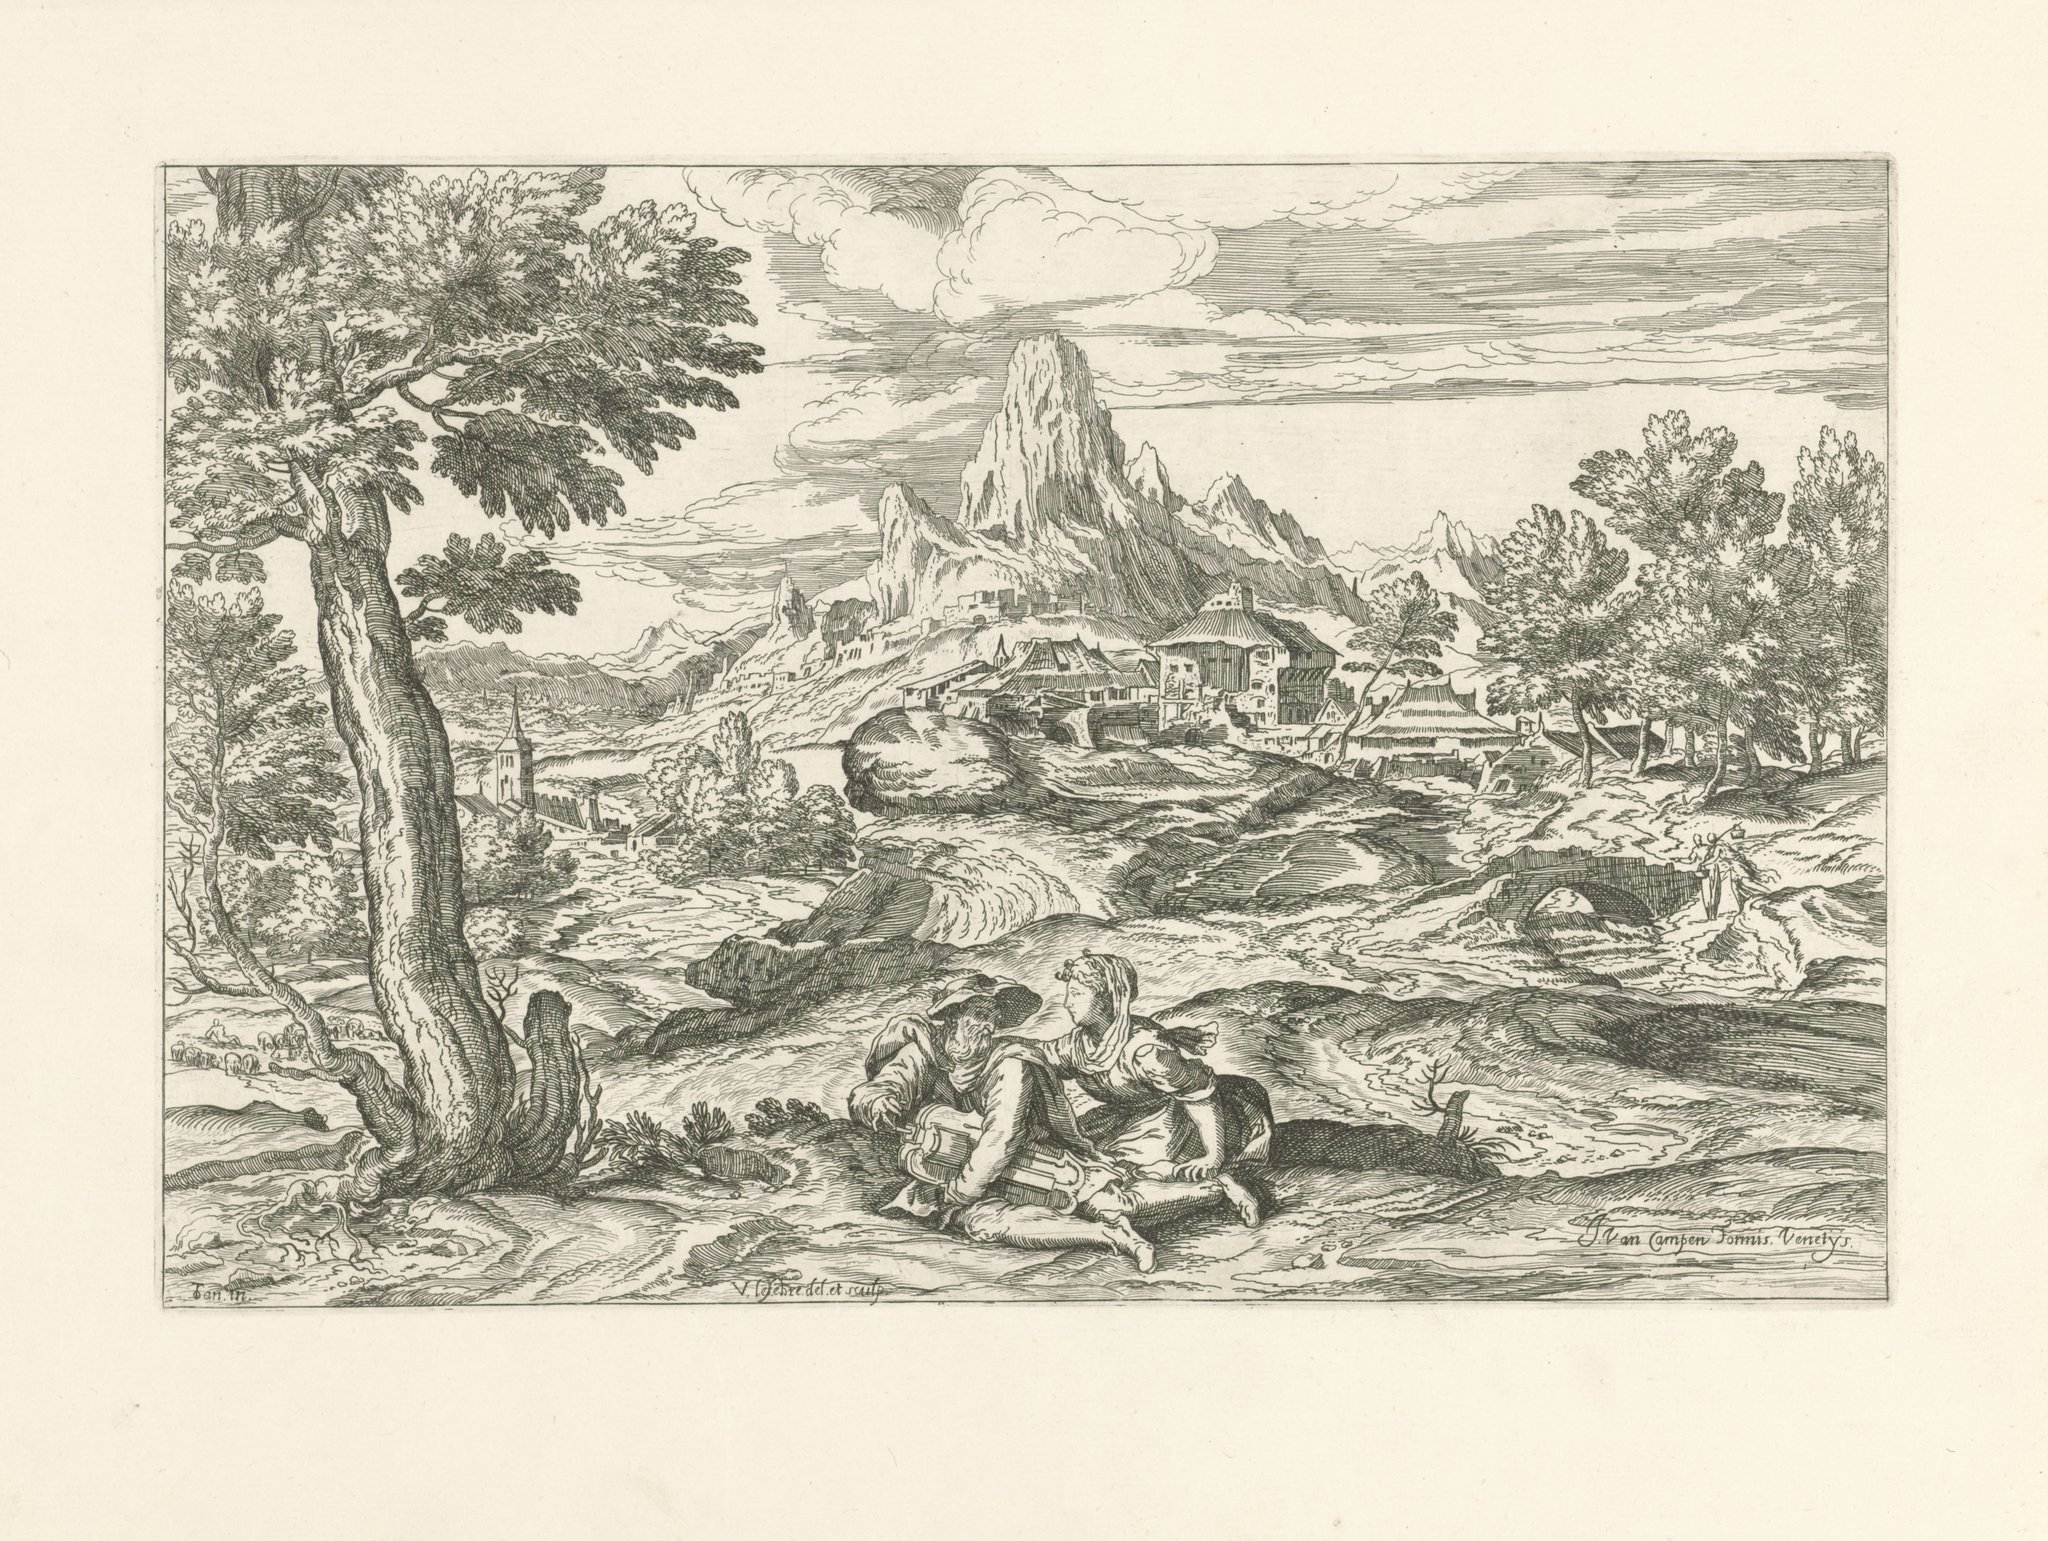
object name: print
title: Bergachtig landschap met draailierspeler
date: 1682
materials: paper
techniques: etching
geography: venice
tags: hurdy-gurdy - cc - out of doors, landscapes with waters, waterscapes, seascapes (in the temperate zone)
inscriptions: collector's mark: Lugt 2228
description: Bergachtig landschap met op de voorgrond een bebaarde oude man die muziek maakt met een draailier. Hij kijkt hierbij naar een jonge vrouw die haar arm om zijn schouder heeft geslagen. In de verte stroomt een beek en liggen huizen. De prent maakt deel uit van een 53-delige serie prenten naar schilderijen van Titiaan en Veronese.